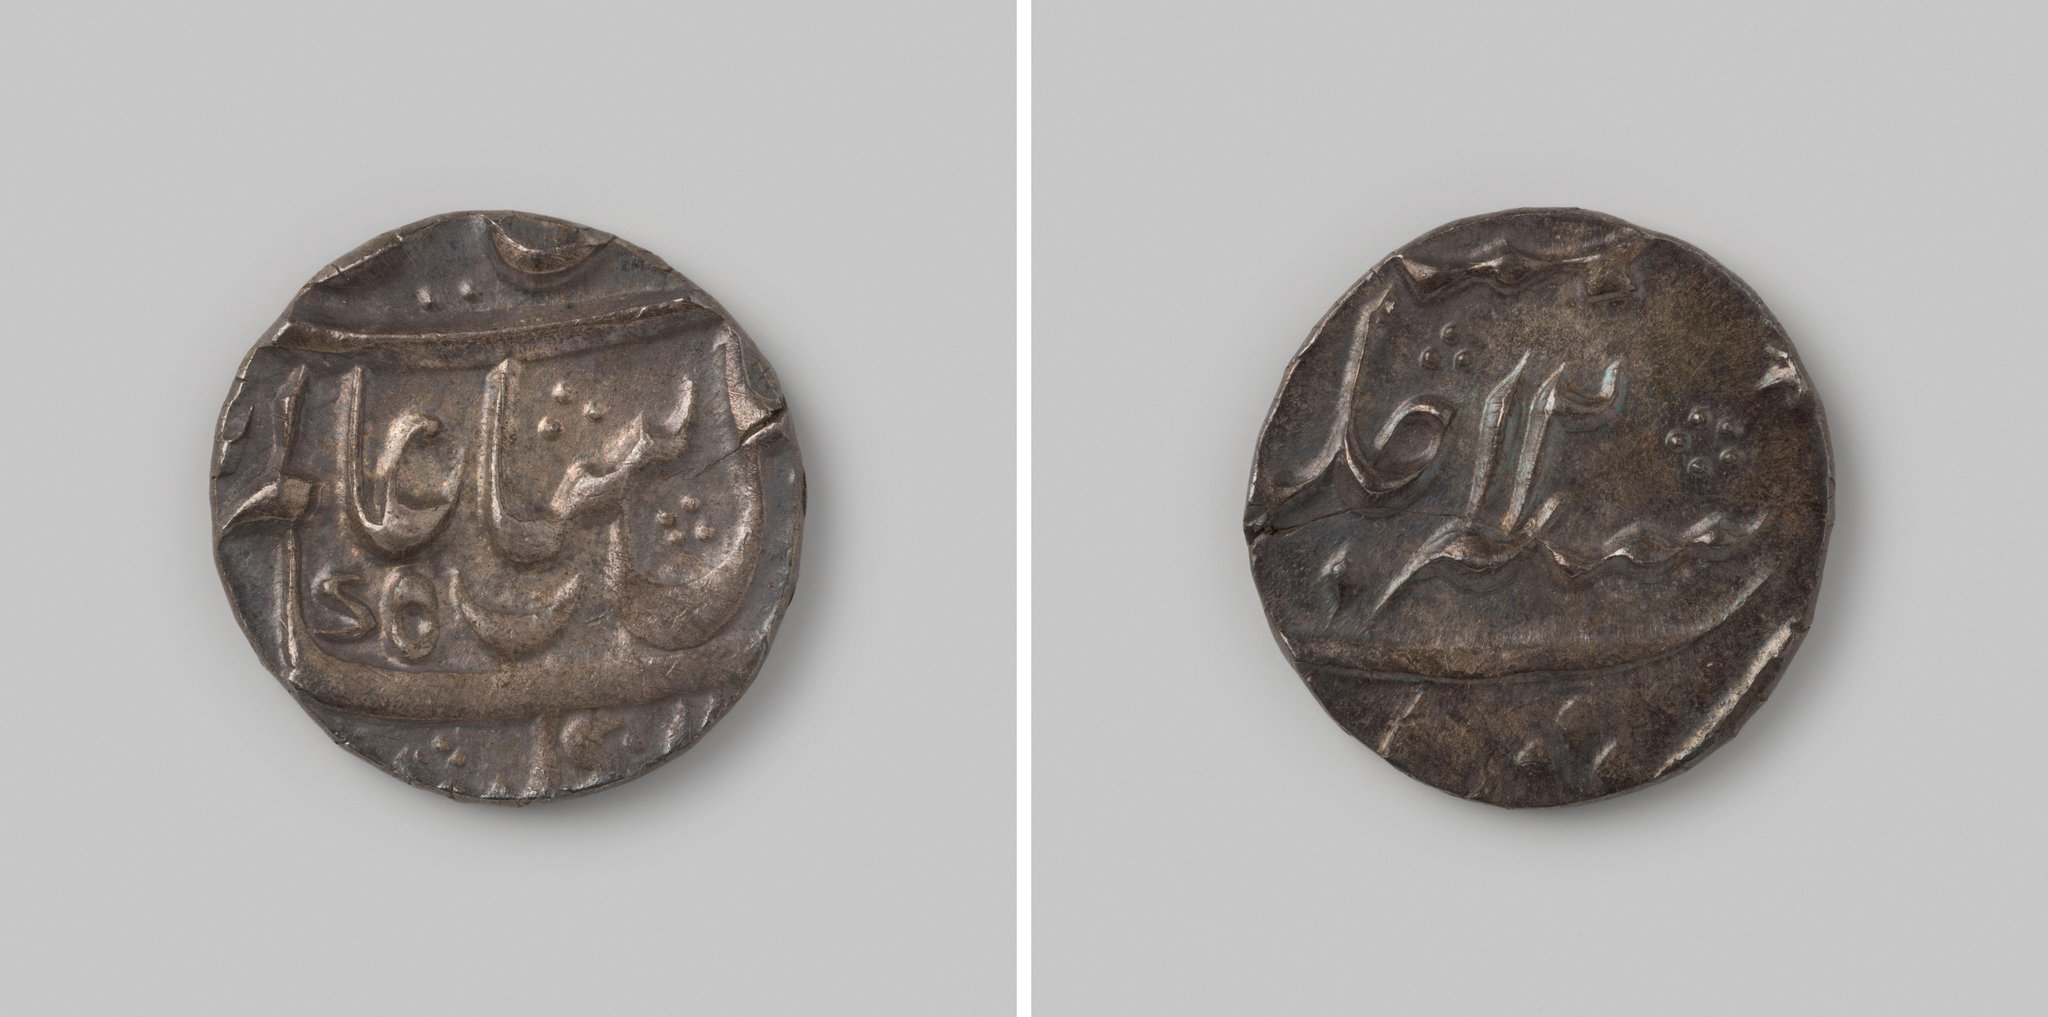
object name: coin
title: ½ roepie uit Bengalen in India van de Engelse Oostindische Compagnie (EIC) op naam van Sjah Alam I,1185 [=1771]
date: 1771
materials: silver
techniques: striking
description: Zilveren munt. Voorzijde: in Arabische lettertekens in drie regels opschrift met onderaan aanduiding jaartal: 1185. Keerzijde: in Arabische lettertekens in drie regels opschrift. Boven tweede regel aanduiding regeringsjaaar: 12 met uiterst rechts daarvan (gedeelte van een) ster [=muntplaats Murshidabad]. Gladde rand.